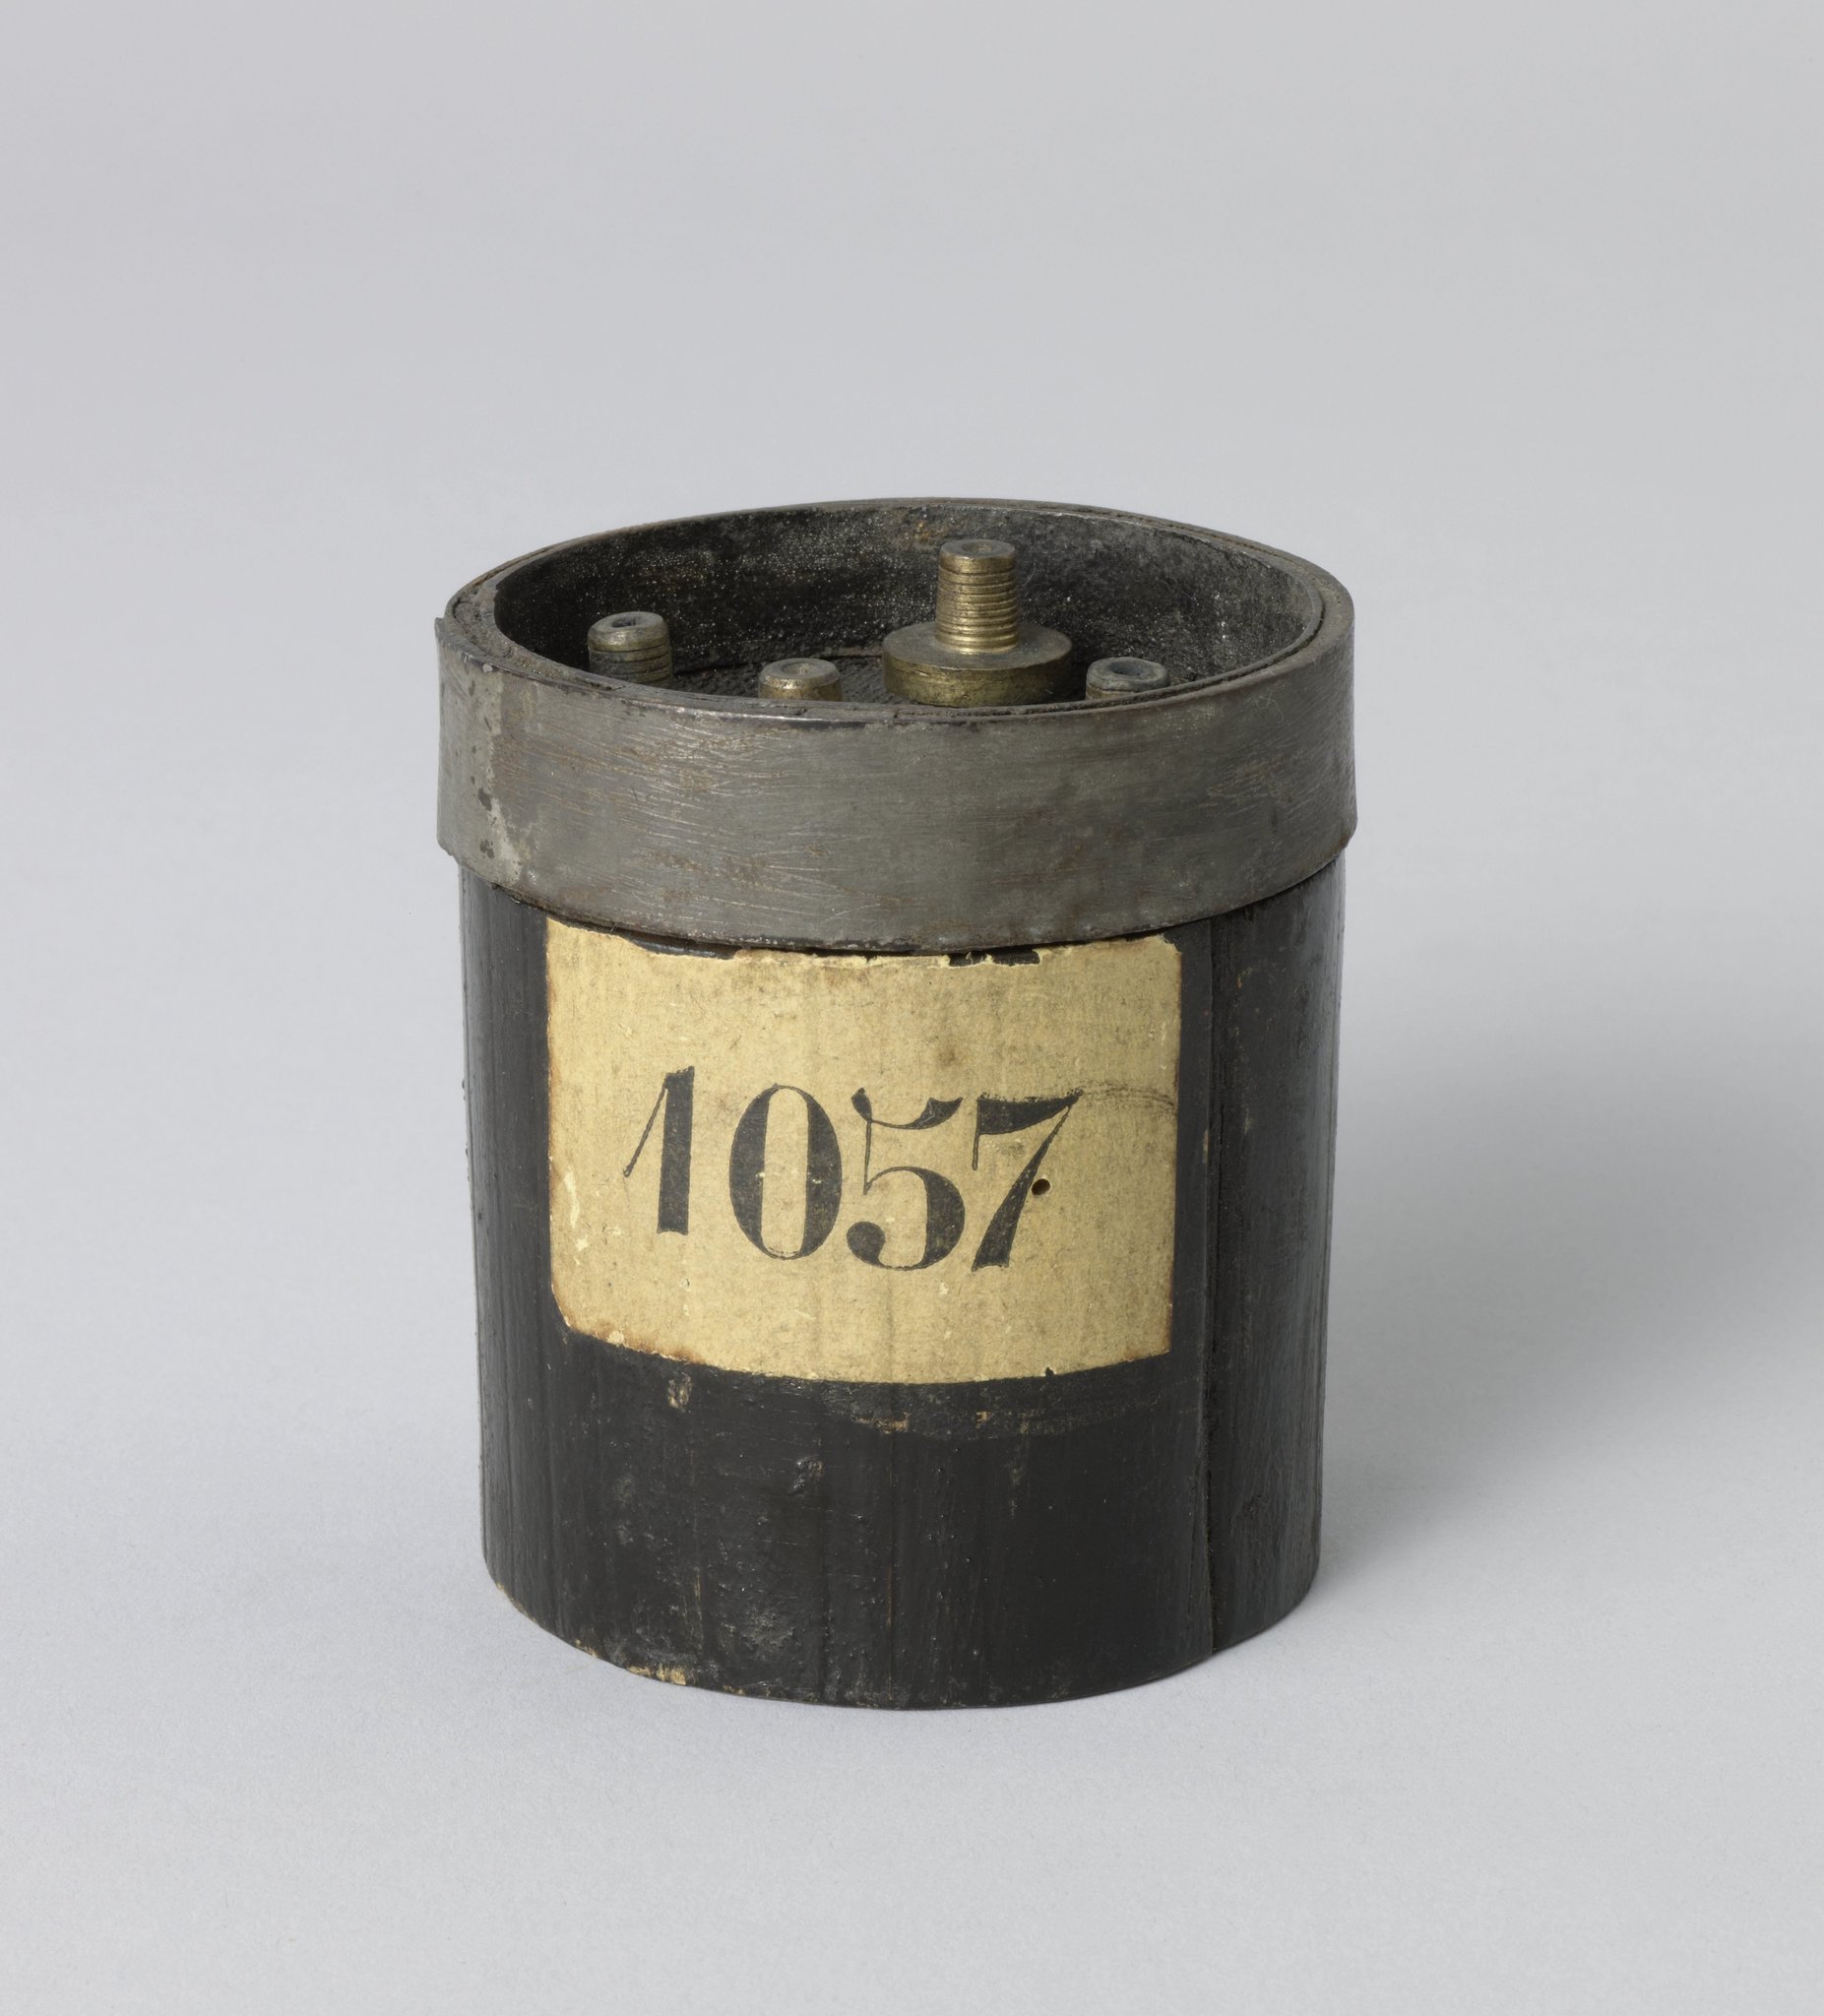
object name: demonstration model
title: Shrapnel Shell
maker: p.j. missiaan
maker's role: artillerist, uitvinder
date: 1859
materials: brass, coal, iron, rattan, wood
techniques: coal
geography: netherlands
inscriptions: label, centre: ‘1057’ former inventory label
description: Granaat-kartets bestaande uit een houten cylindervormig lichaam en een houten deksel met opstaande rand beslagen met blik. In het deksel zijn vier slagpijpjes aangebracht en in het midden een gat. Binnen in de granaat is wat steenkoolgruis achtergebleven en een kort eindje rotan.